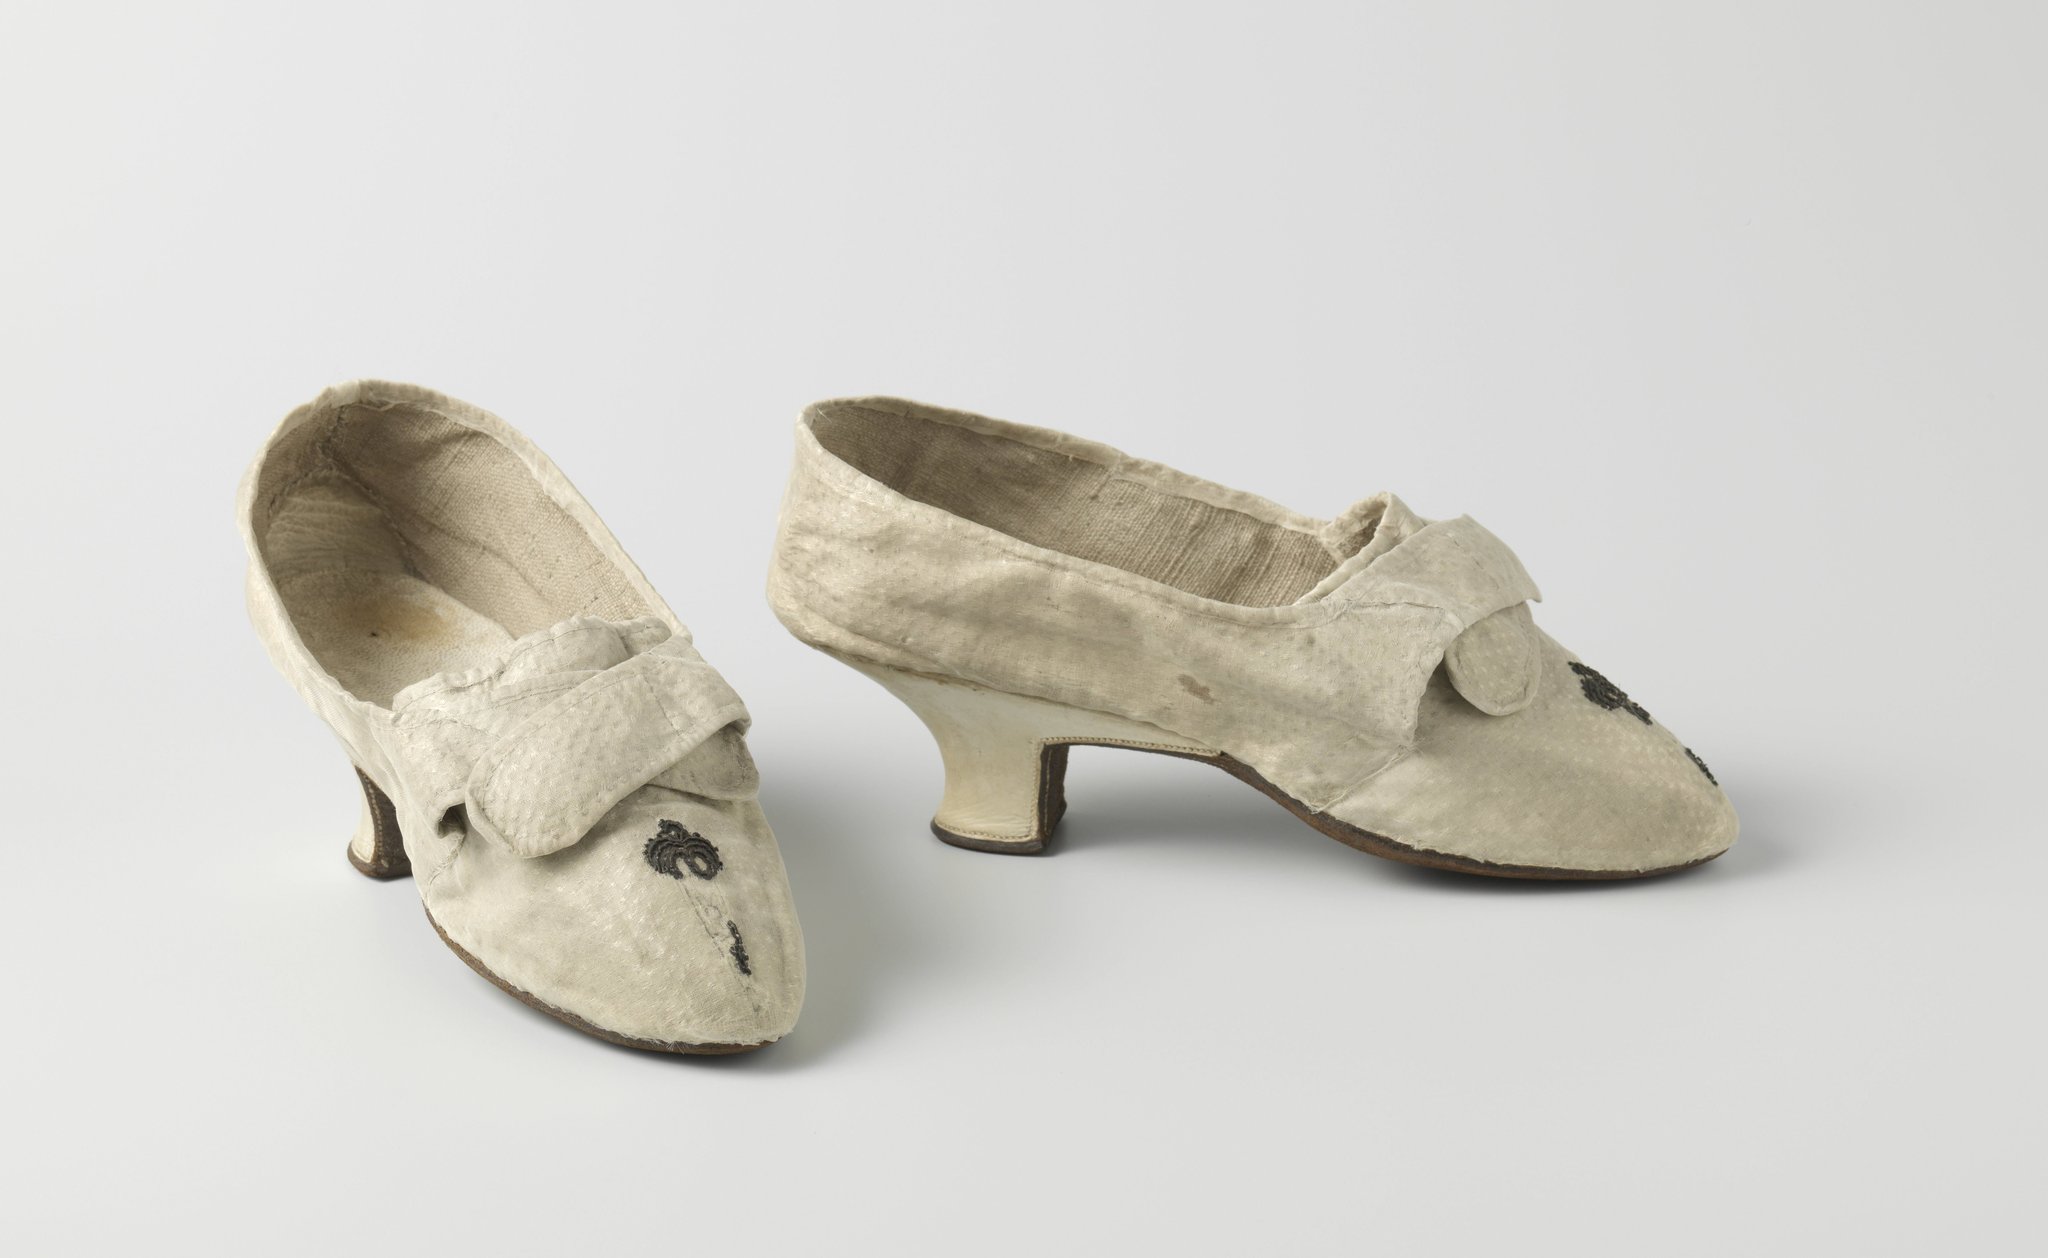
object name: damesschoen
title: Damesschoen van crèmekleurig genopte zijde, op de neus versierd met zilveren lovers en canetille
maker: Anonymous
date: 1770-1780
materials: leather, linen, silk, silver, wood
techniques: tanning, weave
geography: netherlands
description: Damesschoen van crèmekleurig genopte zijde. Afgeronde neus, één voorblad en twee zijbladen.Op de stikseld, die de bladen bij elkaar houden, hebben oorspronkelijk crèmekleurige banden gezeten. Vierkante tong op de wreef. Over de tong lopen vanaf de zijbladen twee flappen kruislings over elkaar. De voorkant van de hak loopt vanaf het geleng in een rechte hoek recht naar beneden. De zijkant en achterkant van de hak zijn getailleerd en bekleed met crèmekleurig leer. De hak heeft een donkerbruine rand leer van het achterlapje. Zijbladen en voorblad gevoerd met beige linnen. In de hiel is een afgerond stuk ivoorwit leer bevestigd. De binnenzool is van ivoorwit leer. Leren achterlapje met houten spijkers aan de hak vastgeslagen en geruwd leren zool. Versiering: Midden op het voorblad van de punt tot halverwege de voorvoet is een versiering van zilveren lovers en canetille. Afgebiesd met crèmekleurige zijde.